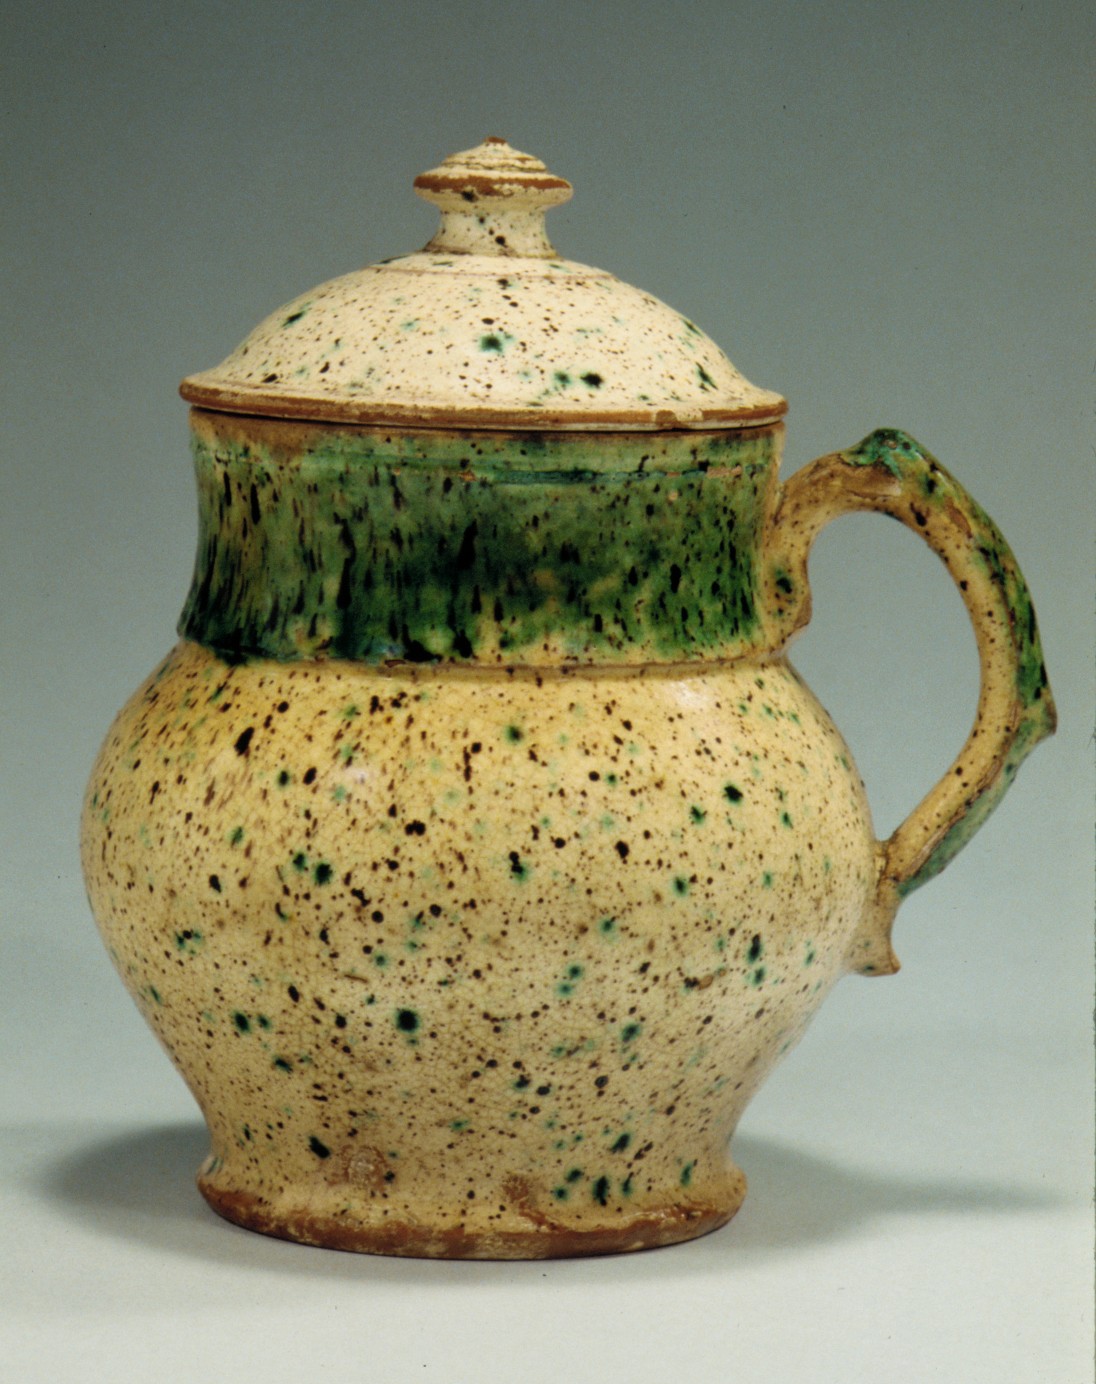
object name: mug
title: Covered mug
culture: american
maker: john bell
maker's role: maker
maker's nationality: american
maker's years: 1800-1880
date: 1830-1850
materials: earthenware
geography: united states